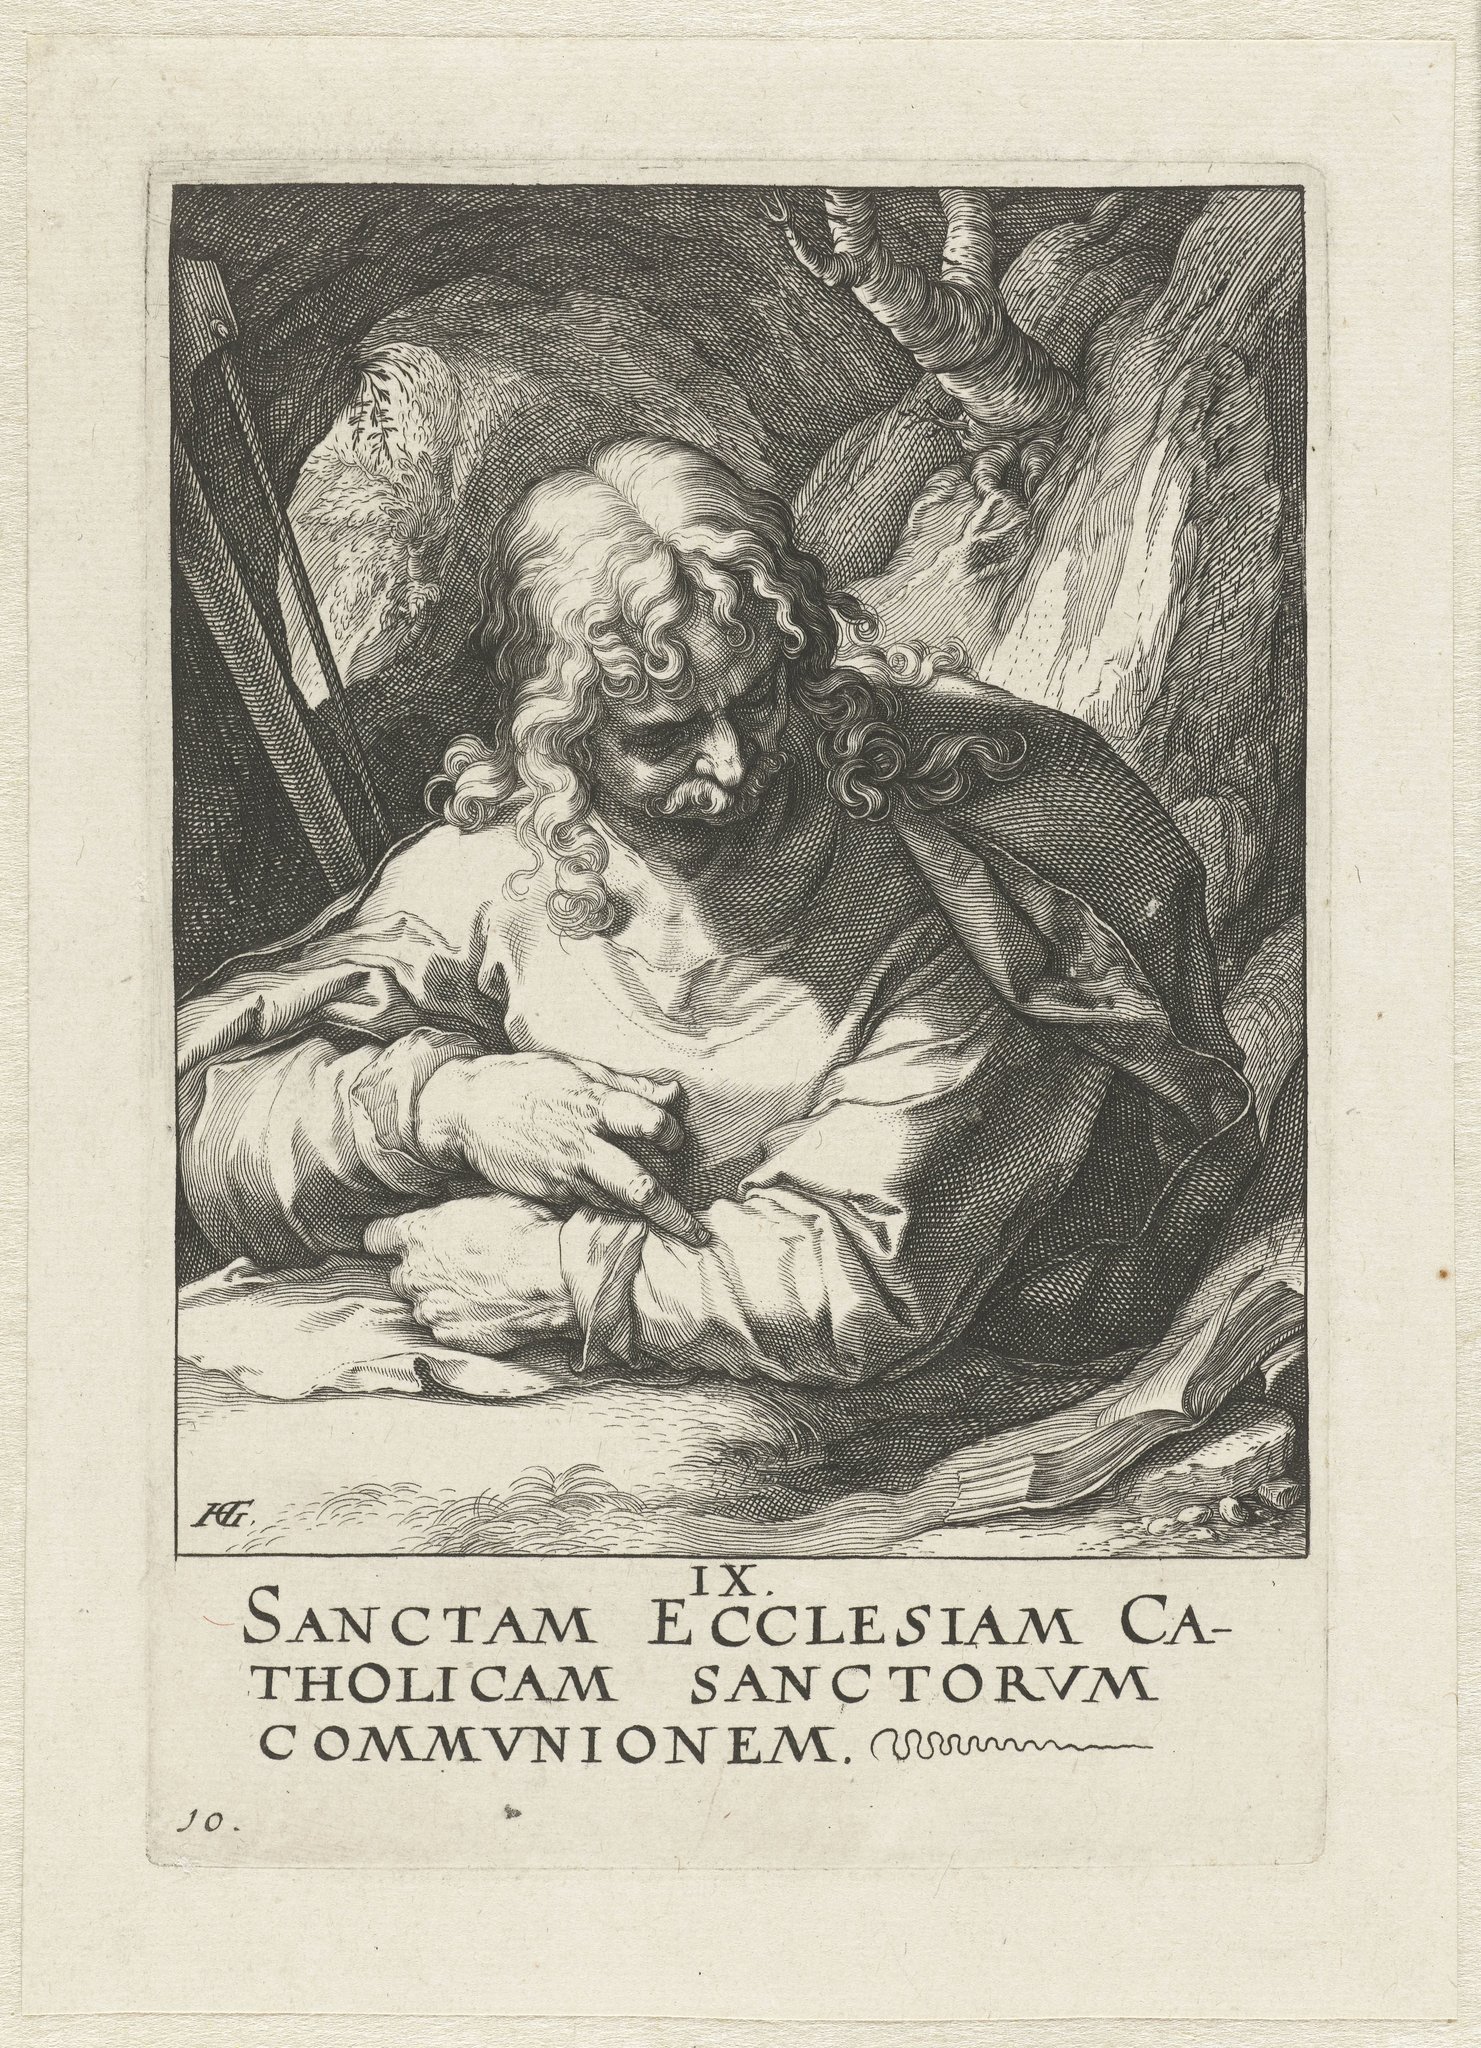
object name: print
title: Christus, de twaalf apostelen en de heilige Paulus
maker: hendrick goltzius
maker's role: draughtsman, painter, print maker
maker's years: 1558-1617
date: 1589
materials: paper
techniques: engraving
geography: haarlem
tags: the apostle james the less, first bishop of jerusalem; possible attributes: book, fuller's club, scroll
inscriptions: collector's mark: Lugt 240, monogram: ‘HG.’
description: De heilige Jakobus de Mindere ten halven lijve, een hoedenmakersboog (?) achter zijn rechterschouder. In marge onder de prent enkele regels Latijn. Prent uit een serie van veertien.